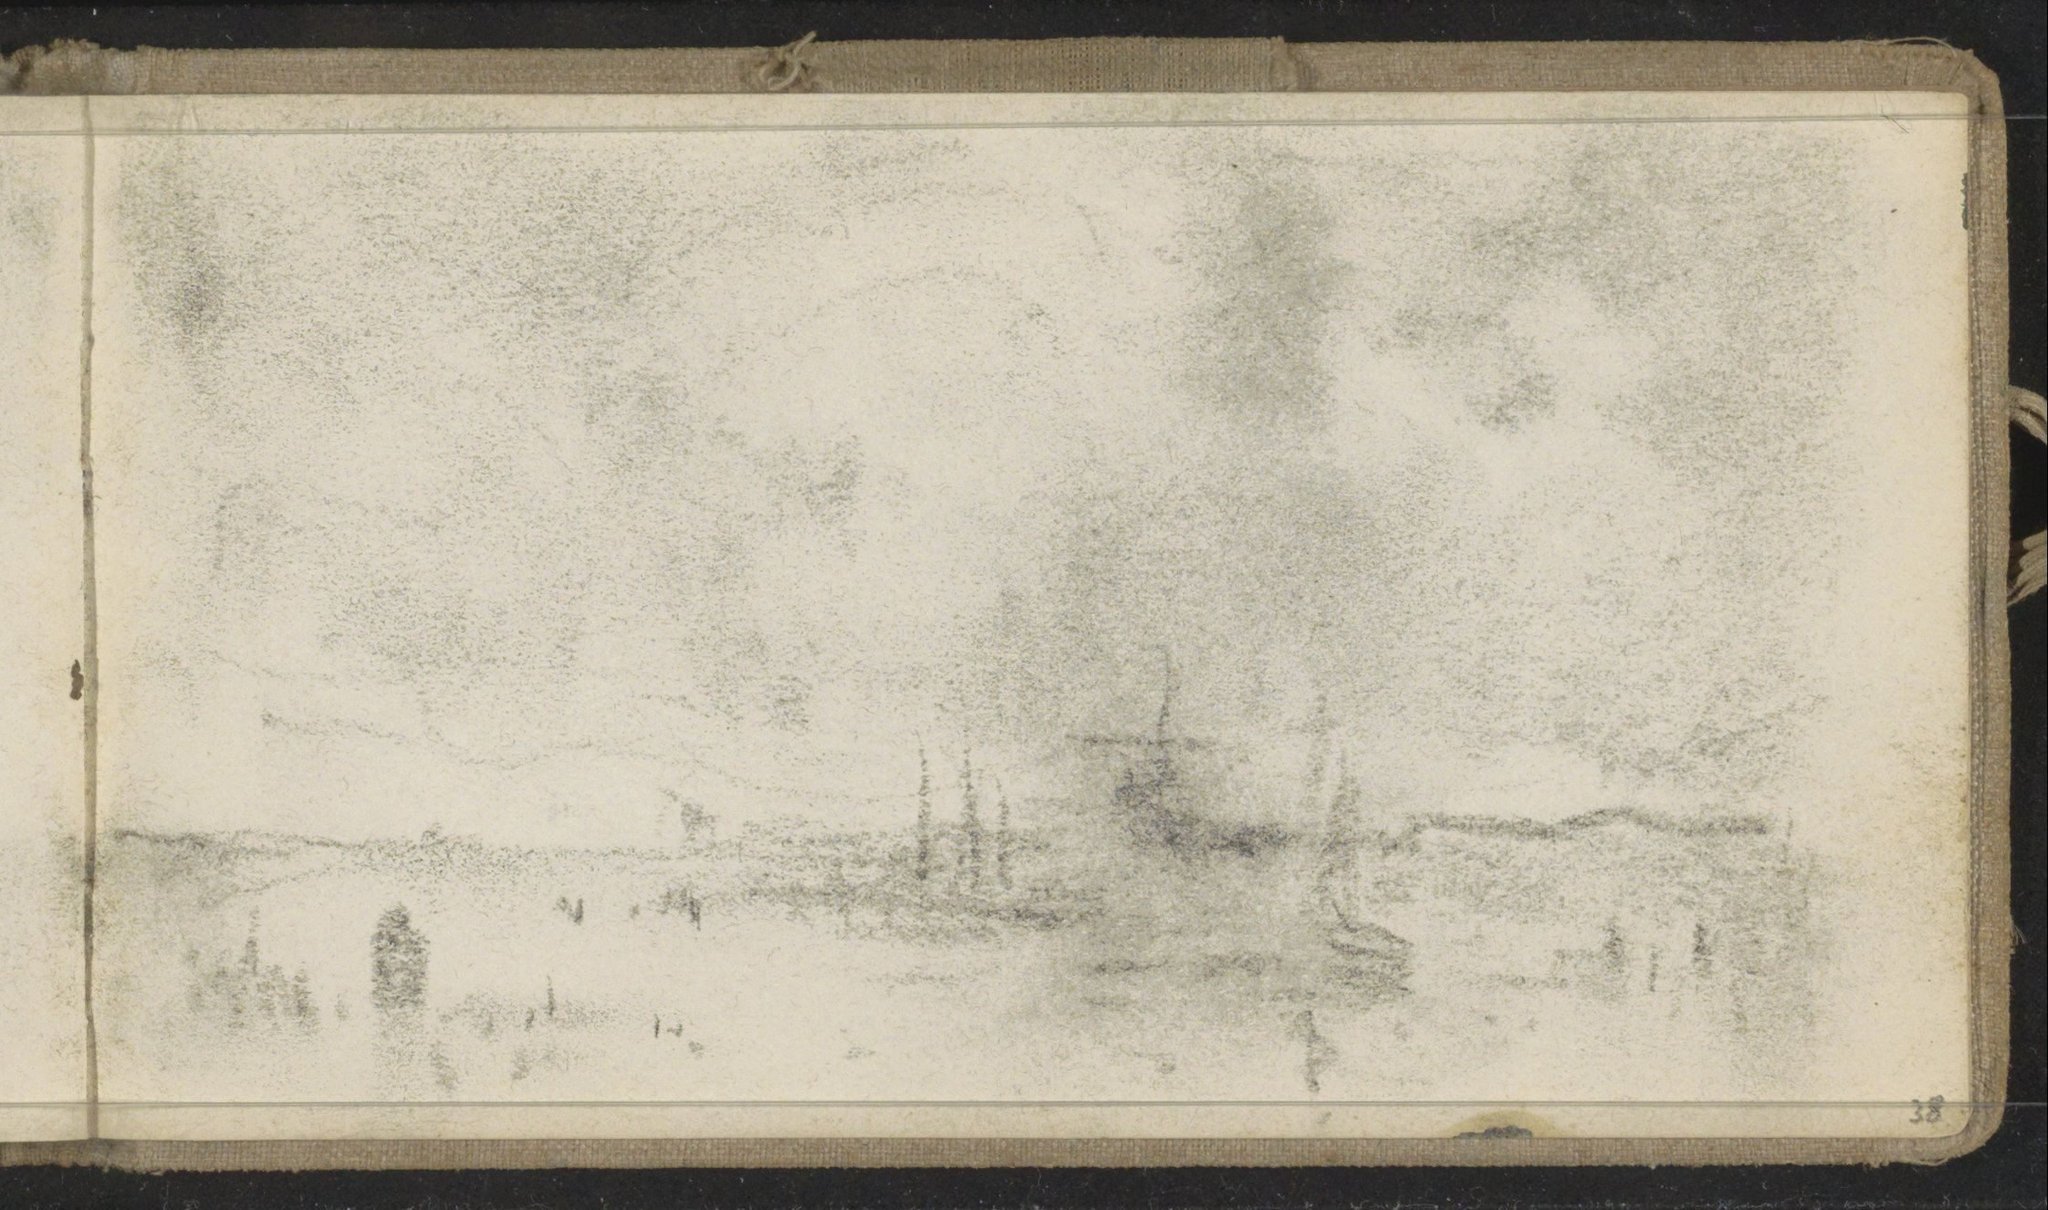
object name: sketchbook leaf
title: Rivierlandschap met molen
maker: willem cornelis rip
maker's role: draughtsman, painter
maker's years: 1856-1922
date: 1895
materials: chalk, paper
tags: landscapes with waters, waterscapes, seascapes (in the temperate zone), windmill in landscape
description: Blad 38 recto uit een schetsboek met 39 bladen.